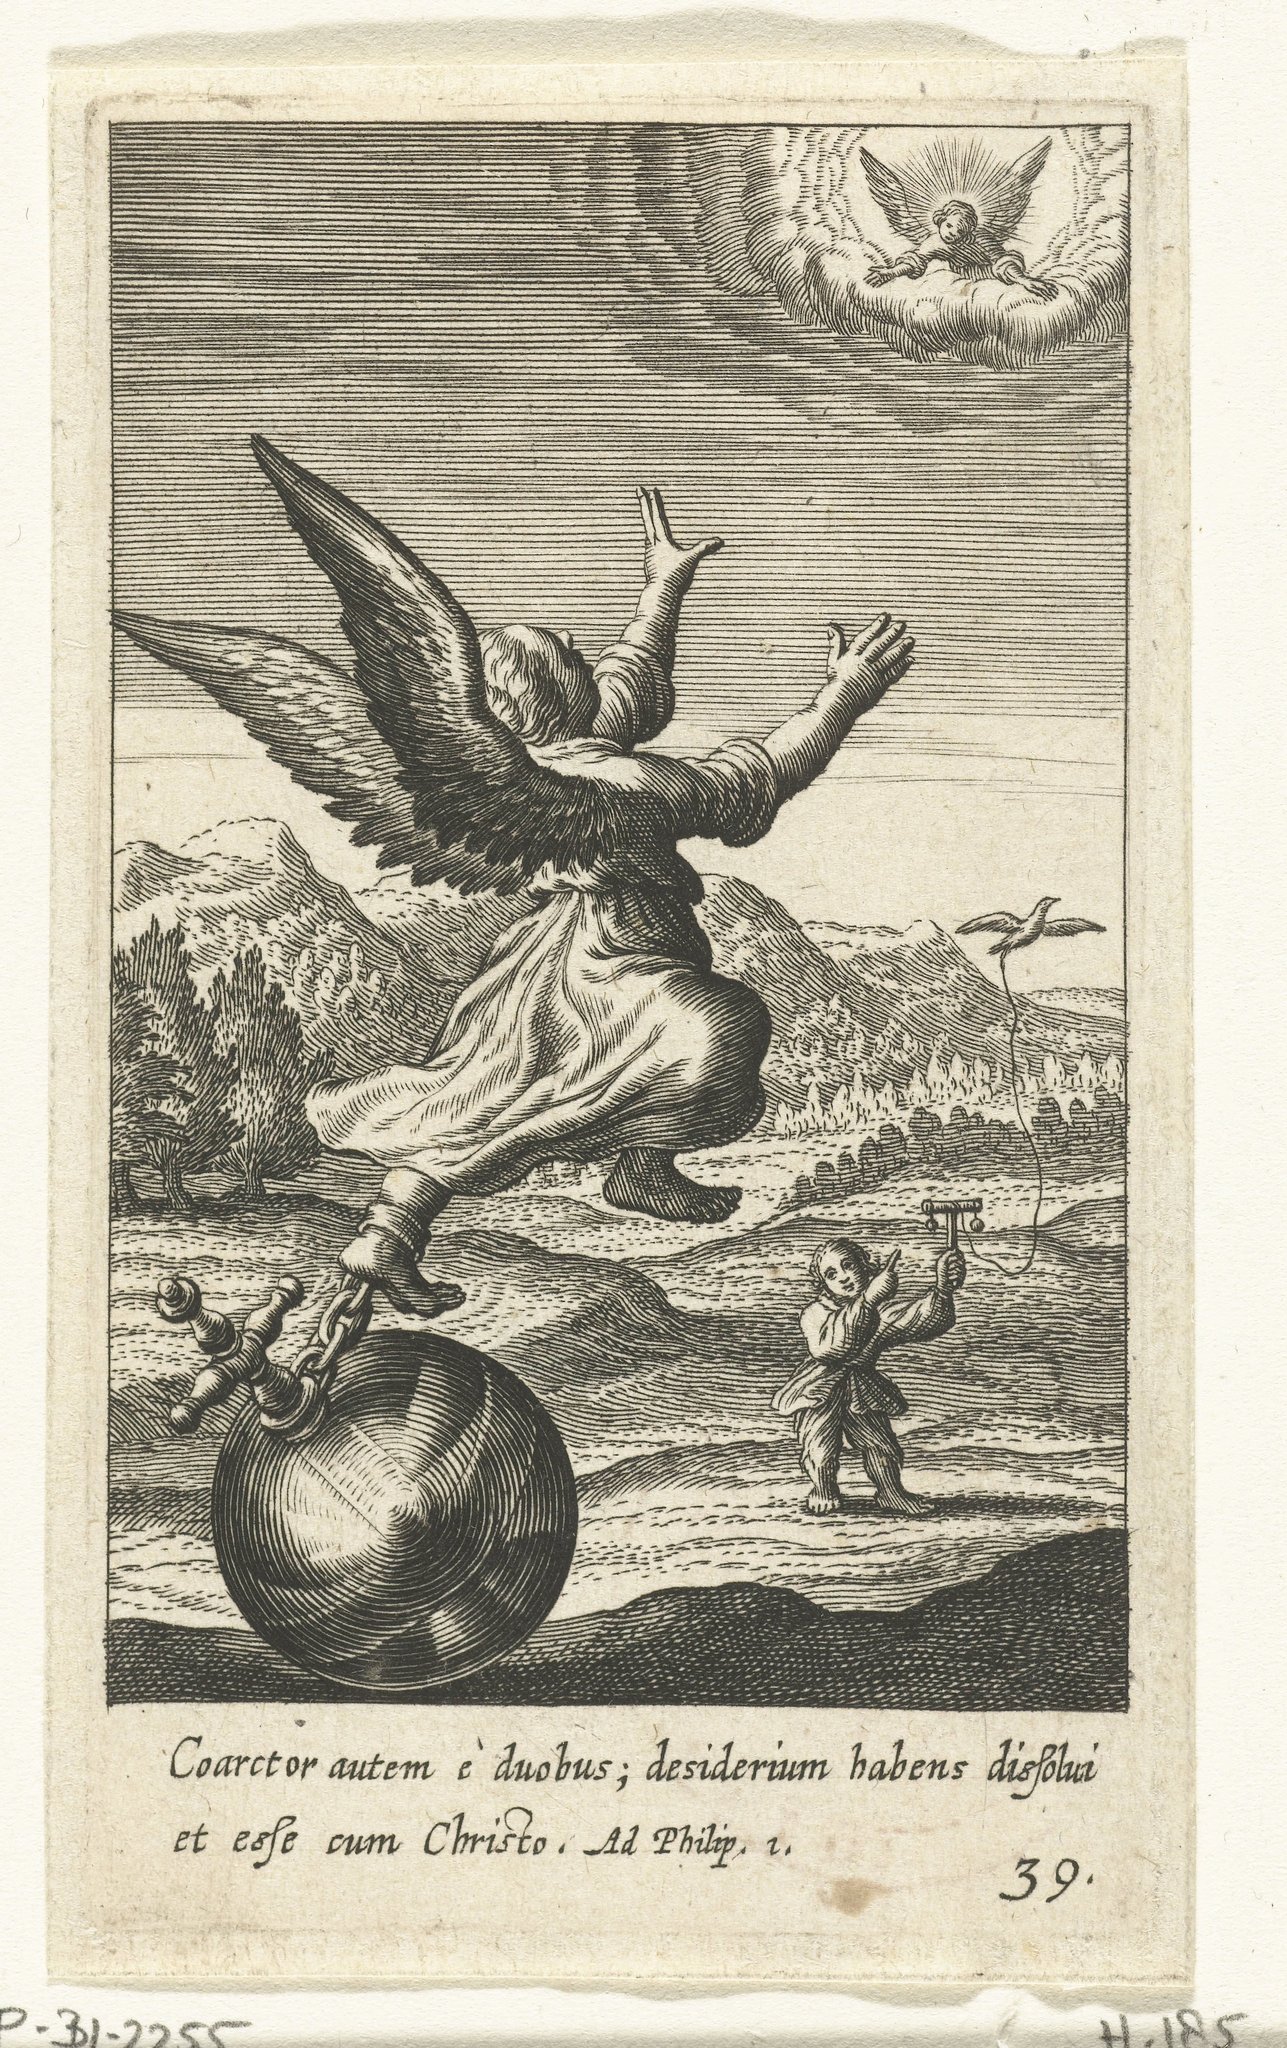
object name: print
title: Pia desideria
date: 1590-1624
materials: paper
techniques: engraving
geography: antwerp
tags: orb (symbol of sovereignty; sphere with cross on top), angel(s) with sceptre and/or globe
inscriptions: collector's mark: Lugt 240, inscription: ‘Coarctor è duobus, desiderium habens dissolui, et esse cum Christo .’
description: Een engel op aarde reikt naar een engel in de hemel maar wordt tegengehouden door de globe die aan zijn voet geketend is. In het landschap staat een kind dat speelt met een vogel die in de lucht vliegt aan een touwtje